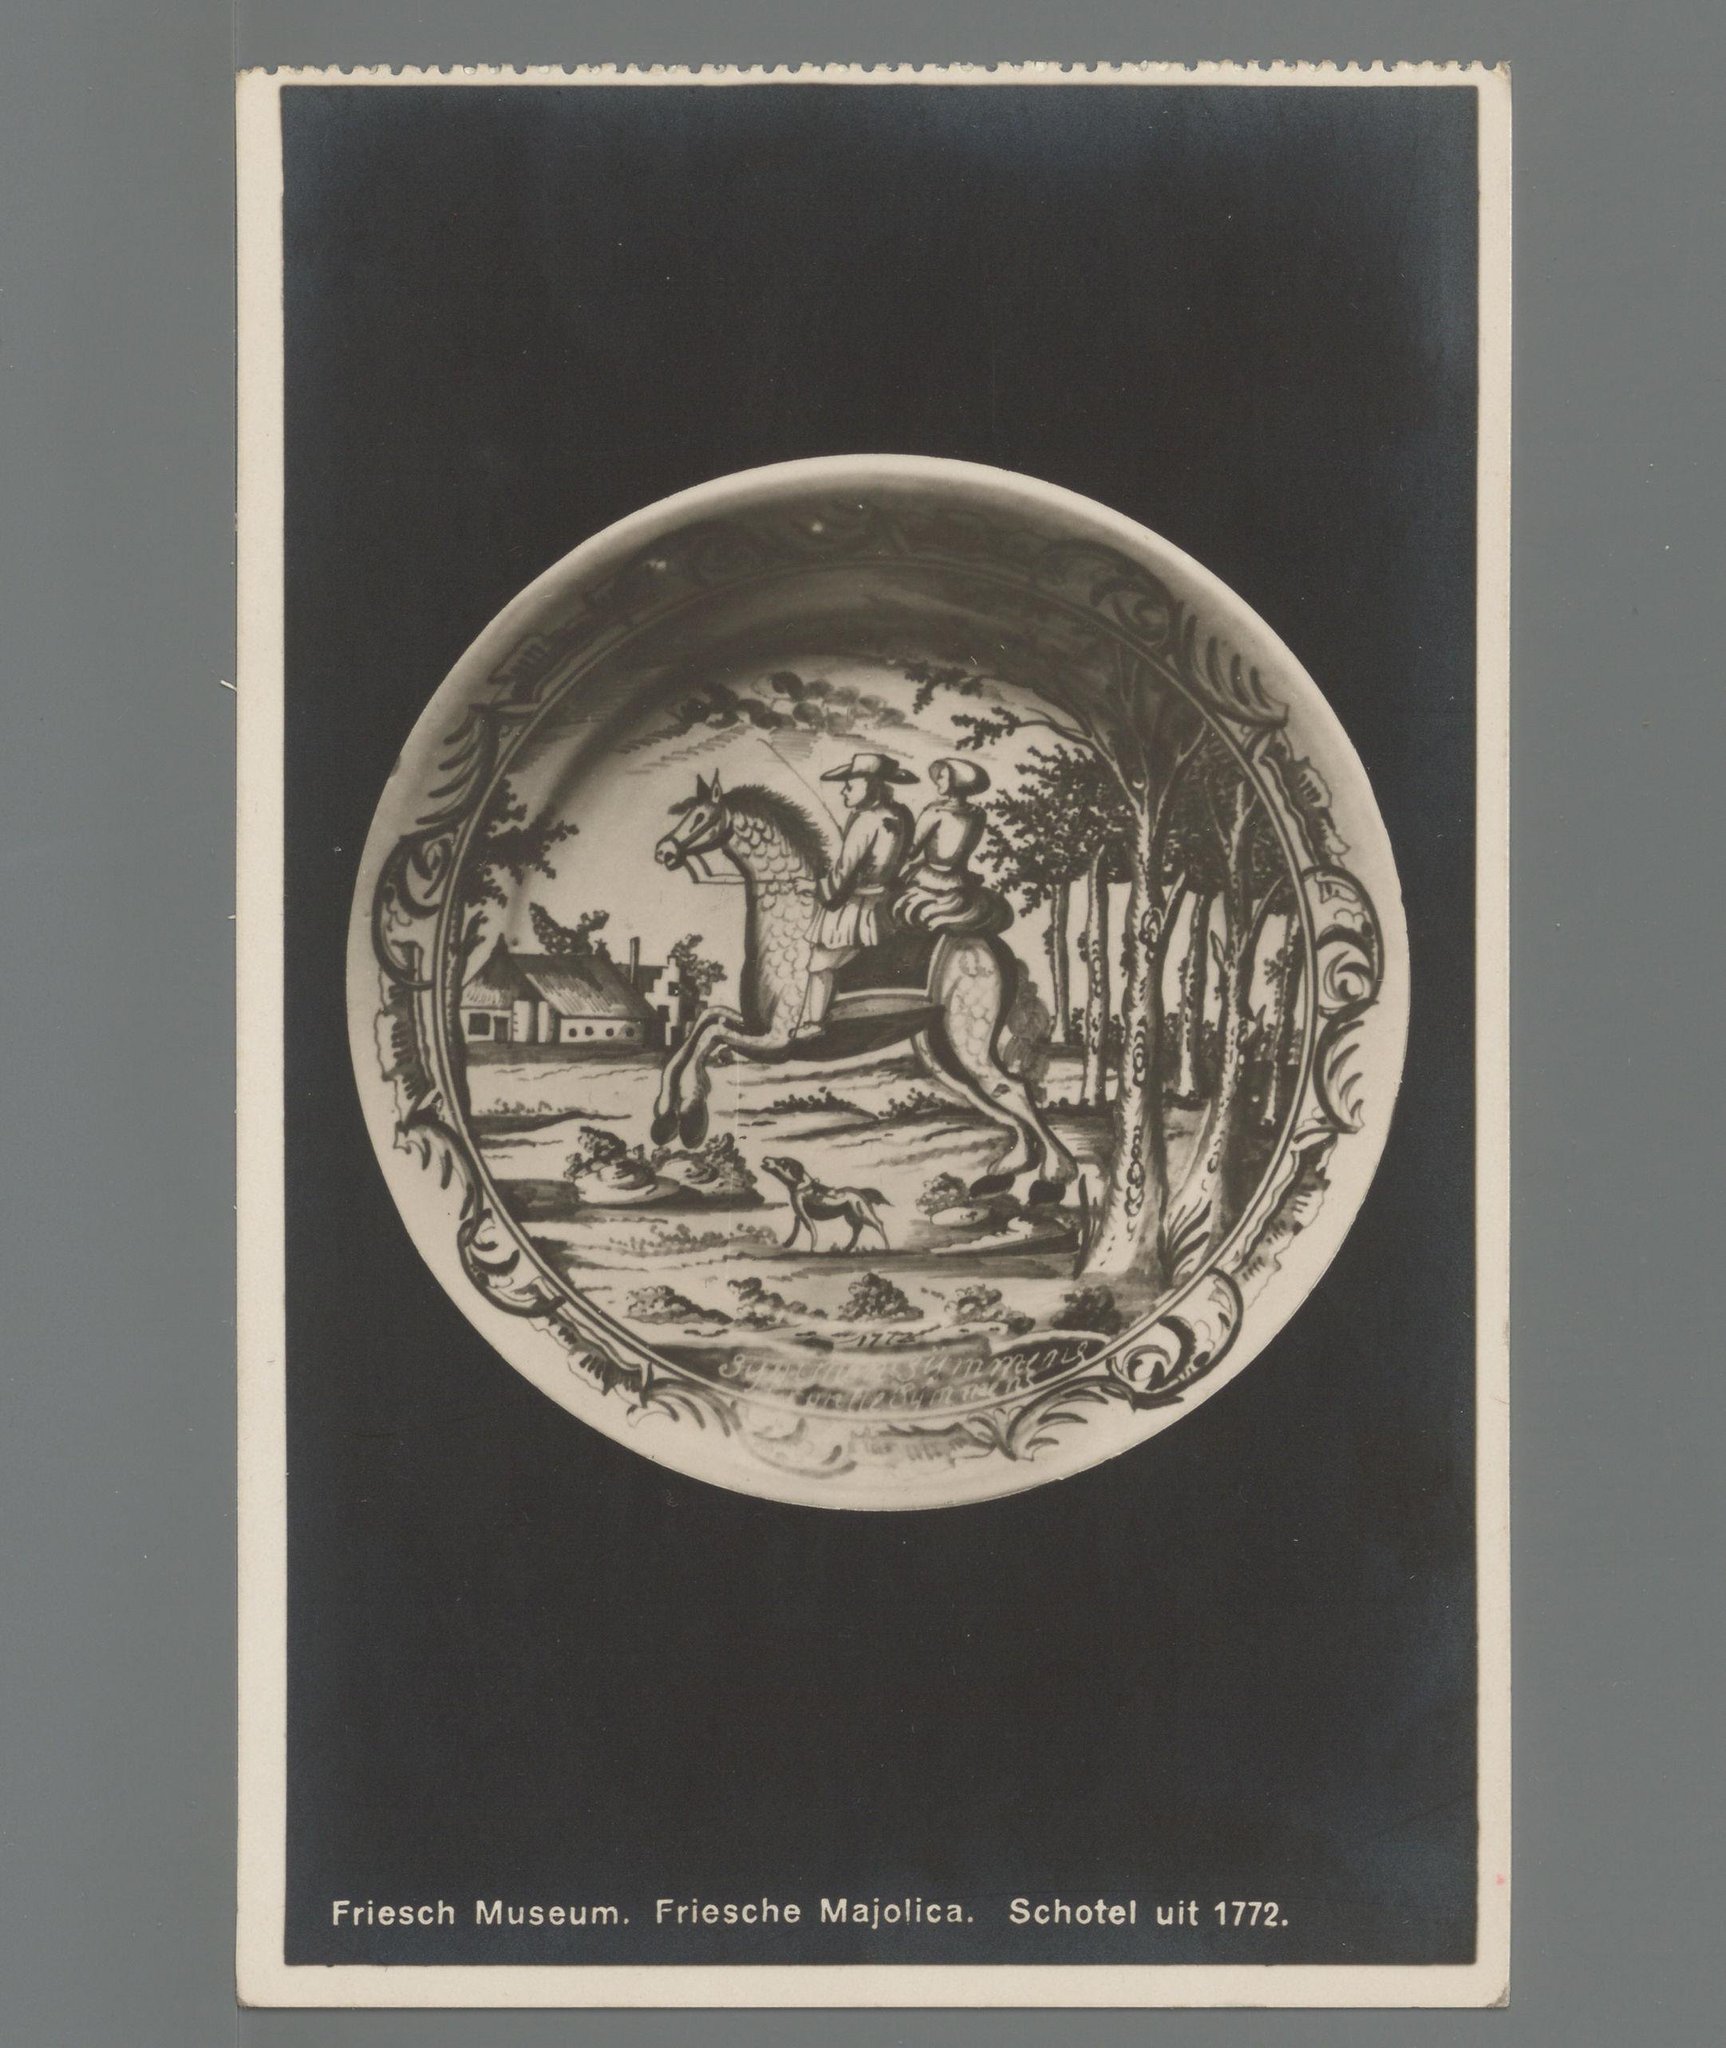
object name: ansichtkaart, prentbriefkaart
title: Friesch Museum. Friesche Majolica. Schotel uit 1772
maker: Anonymous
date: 1927-1935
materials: photographic support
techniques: photography, writing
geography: the hague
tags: picture, painting, dish, plate, saucer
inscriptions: postage stamp